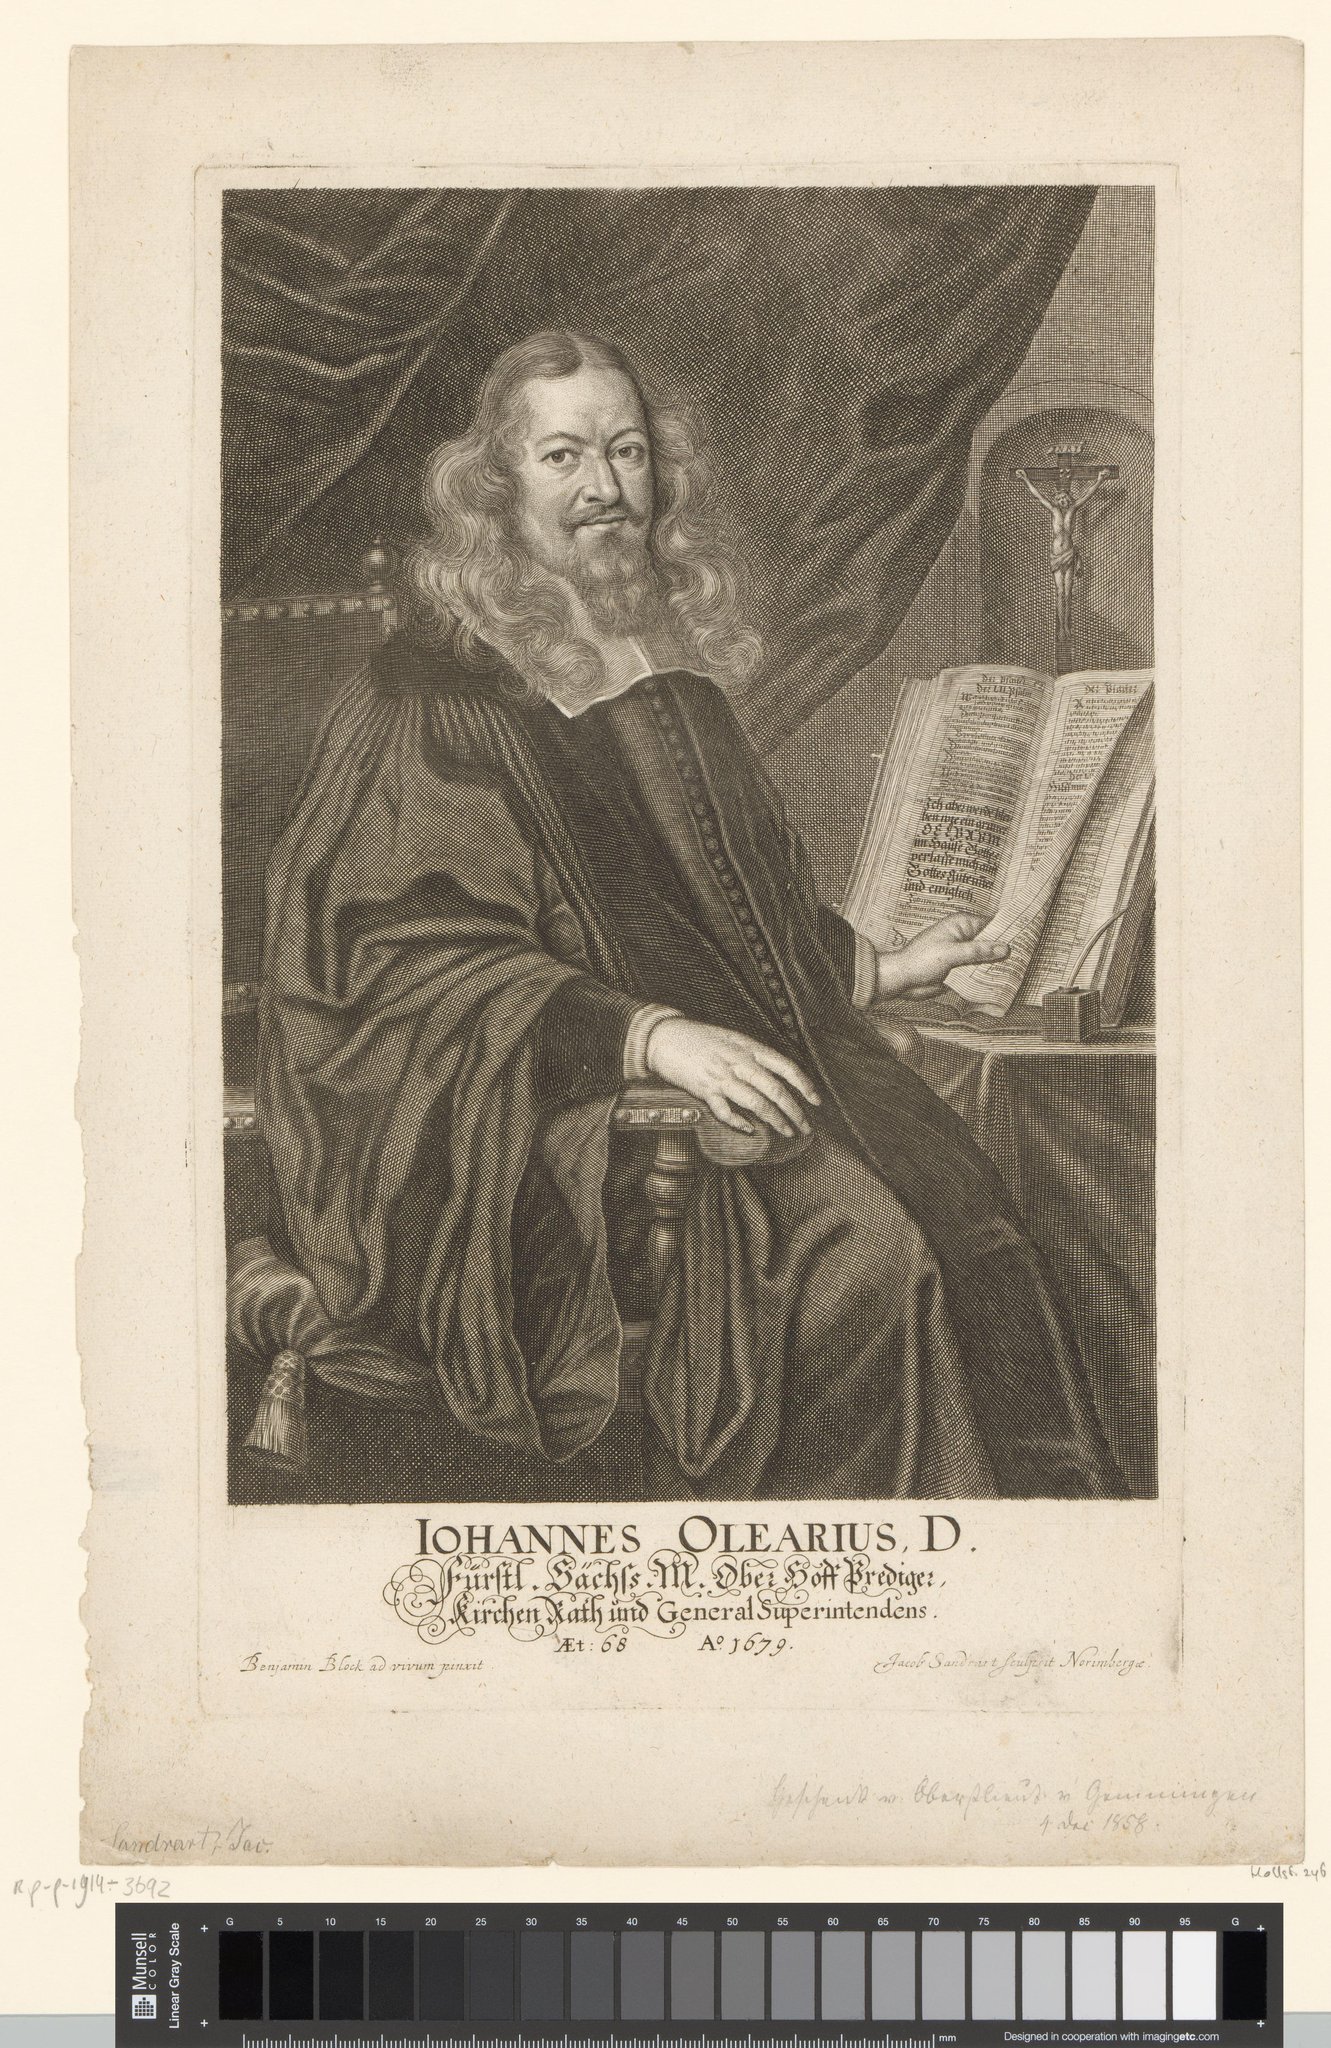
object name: print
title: Portret van Johannes Olearius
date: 1685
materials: paper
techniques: engraving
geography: nuremberg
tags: historical persons, book, crucifix ~ personal devotion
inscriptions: collector's mark: Lugt 2228